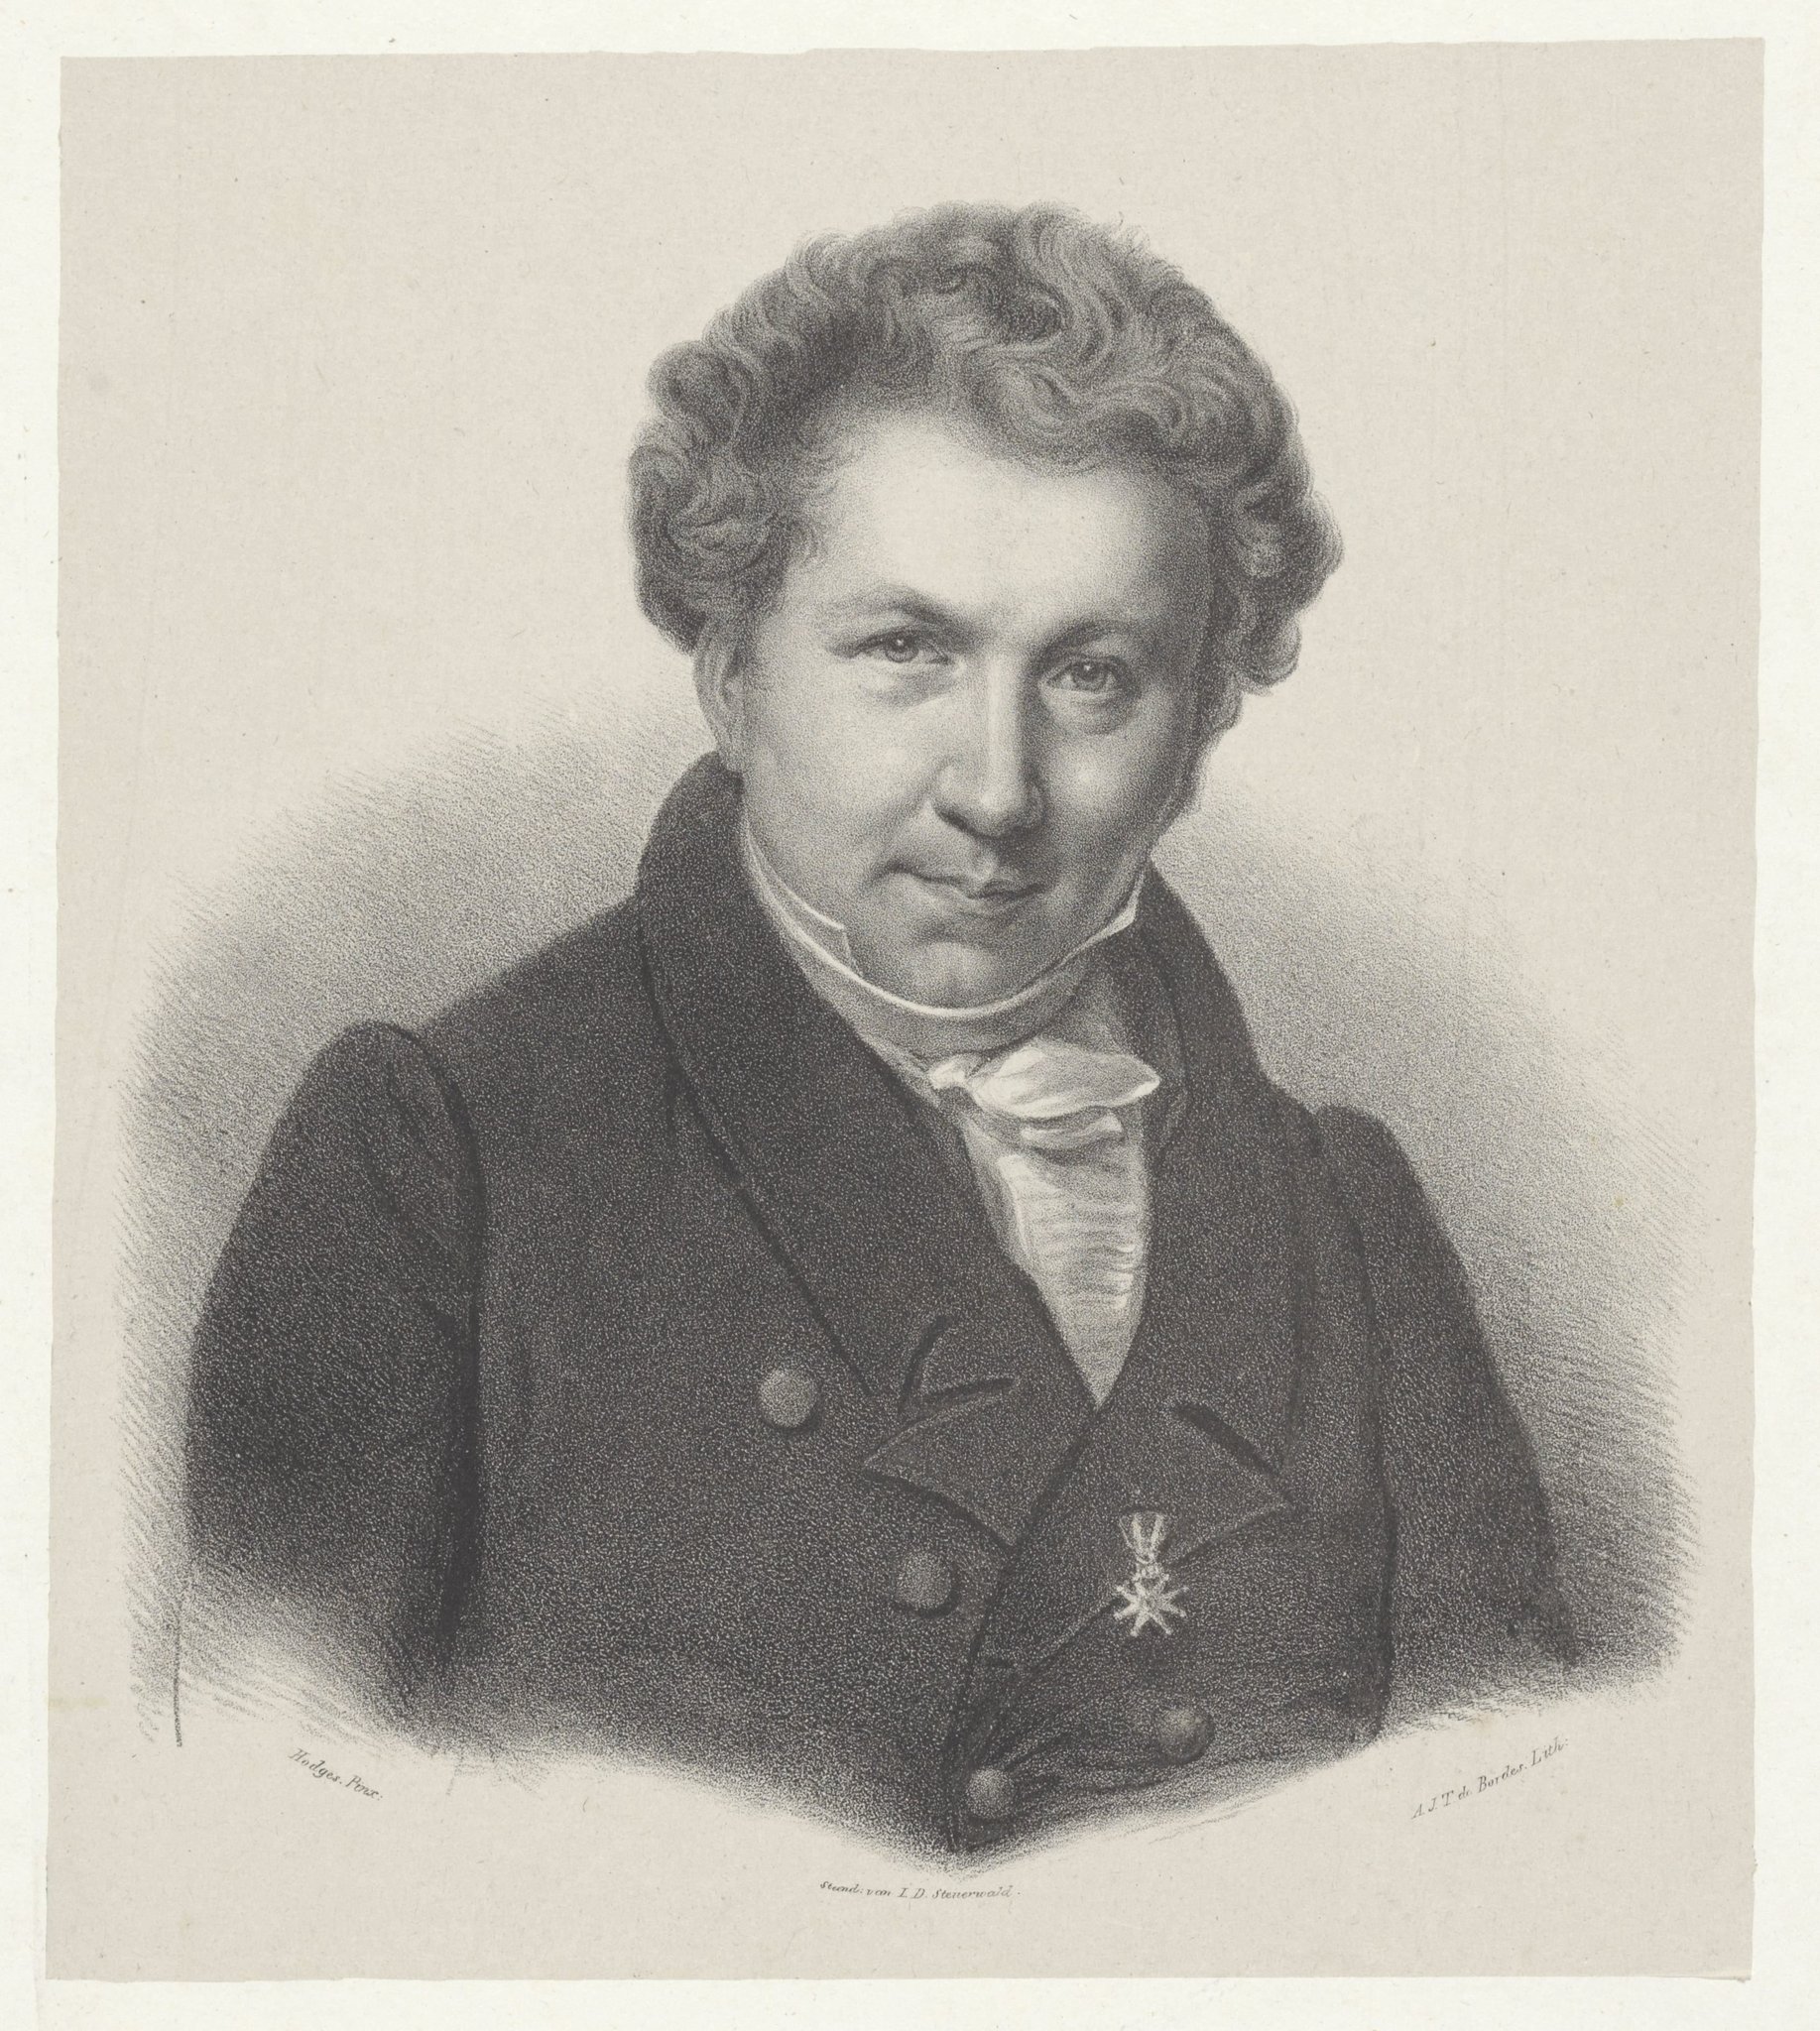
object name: print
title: Portret van Tobie Constantijn de Bordes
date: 1815-1862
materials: paper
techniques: lithograph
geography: netherlands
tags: knighthood order, historical persons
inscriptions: collector's mark: Lugt 2228, collector's mark: Lugt 2760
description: De geportretteerde heeft zijn hoofd licht naar voren gebogen. Hij draagt een ridderorde op de revers van zijn jas.